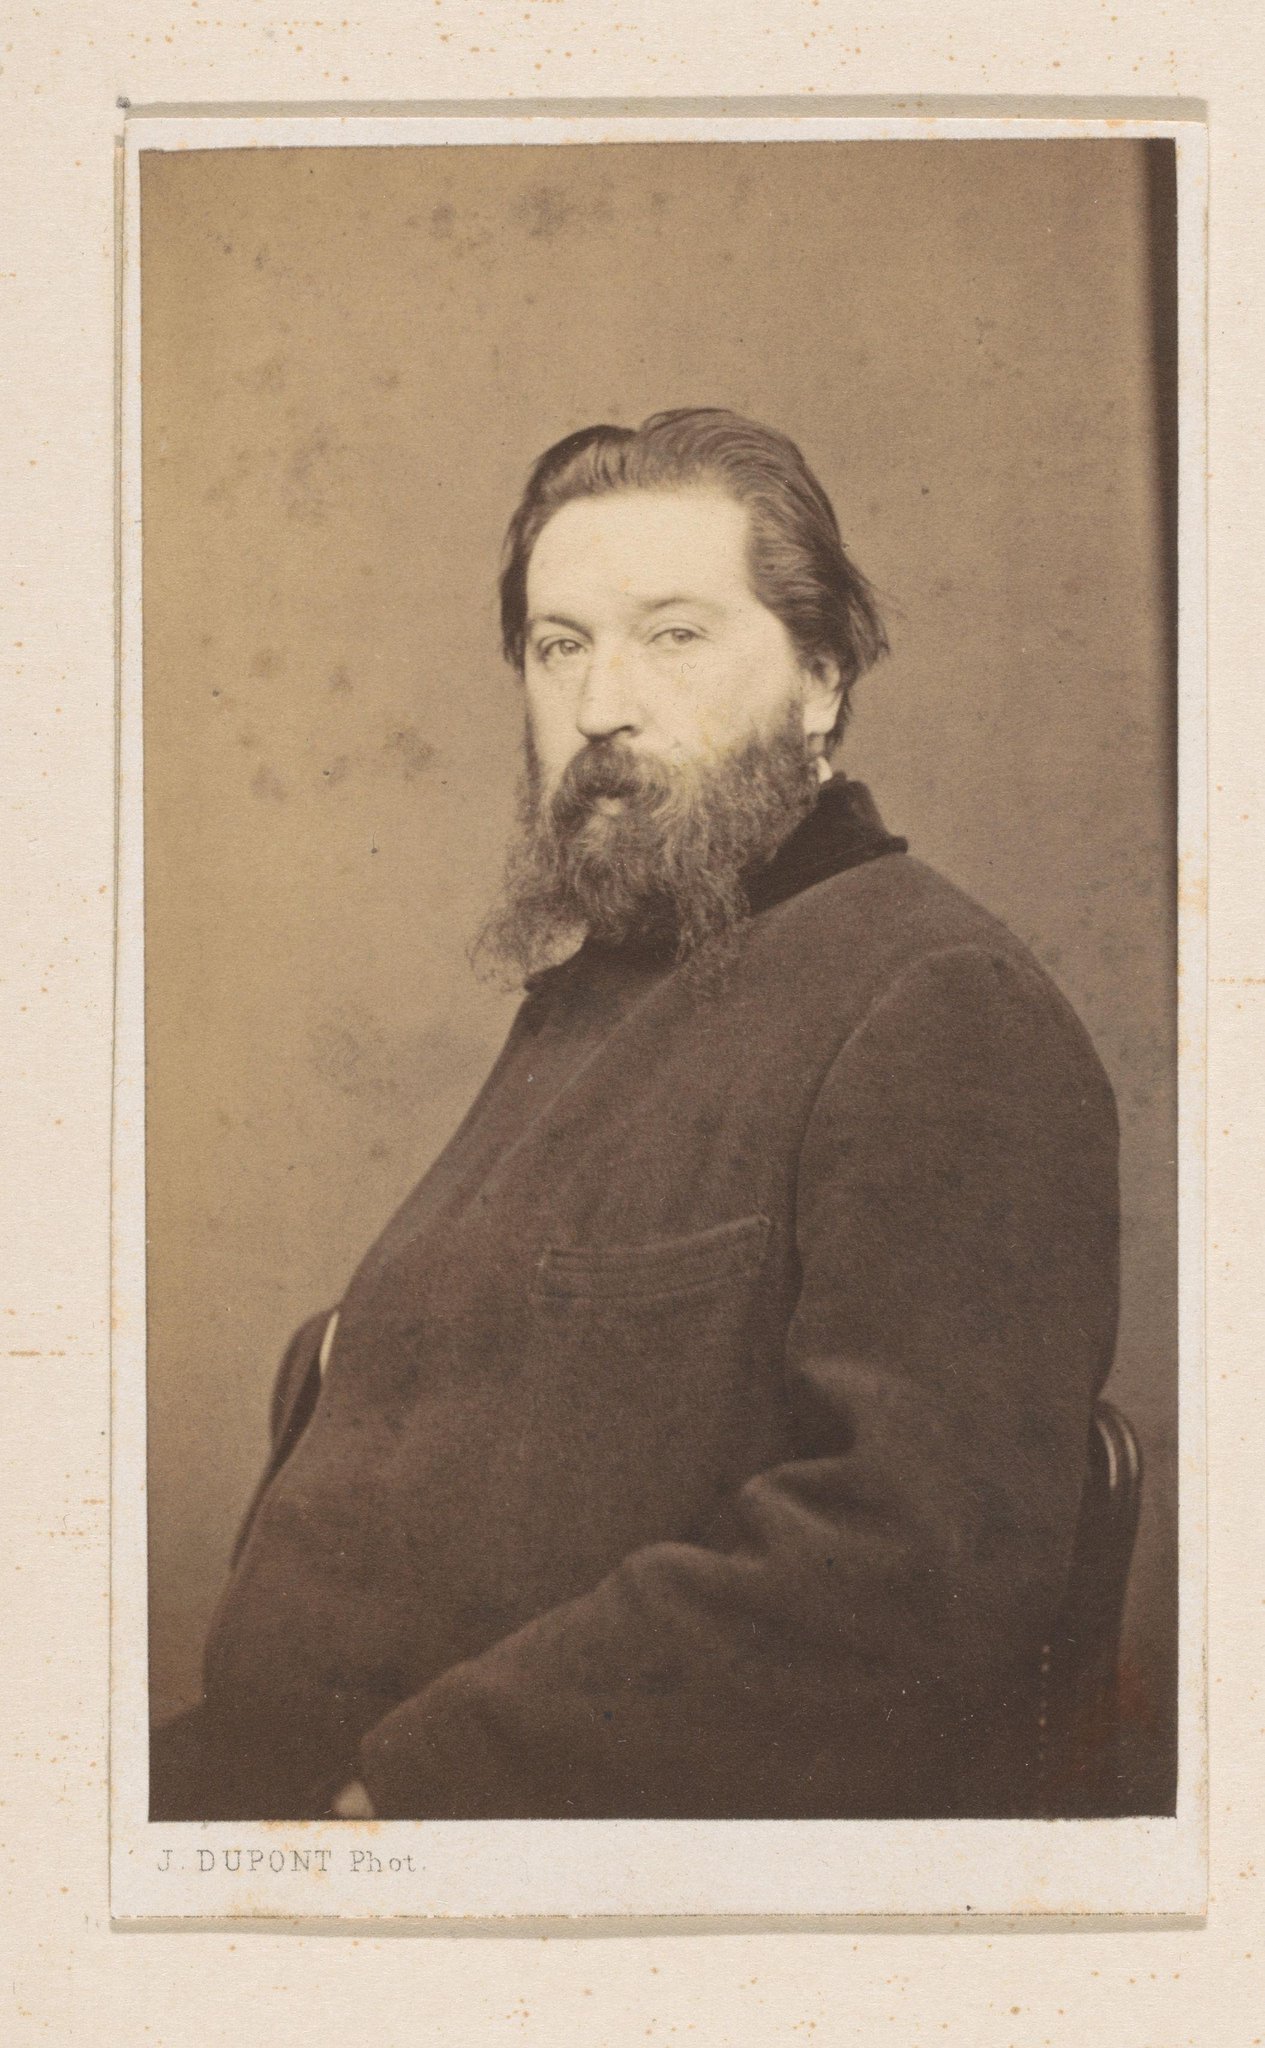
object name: carte de visite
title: L'École d'Anvers. Portraits biographies cartes de visite. Collection Dupont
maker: joseph dupont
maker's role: fotograaf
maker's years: 1818-1901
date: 1861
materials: cardboard, paper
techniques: albumen print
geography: antwerp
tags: antwerp, marienbad, painter, jan swerts, historical persons, portrait, self-portrait of painter, portrait, self-portrait of artist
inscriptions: inscription: ‘ETABLISSEMENT PHOTOGRAPHIQUE/ de/ J. DUPONT/ Place de Meir 32/ ANVERS/ Maison fondée en 1853’